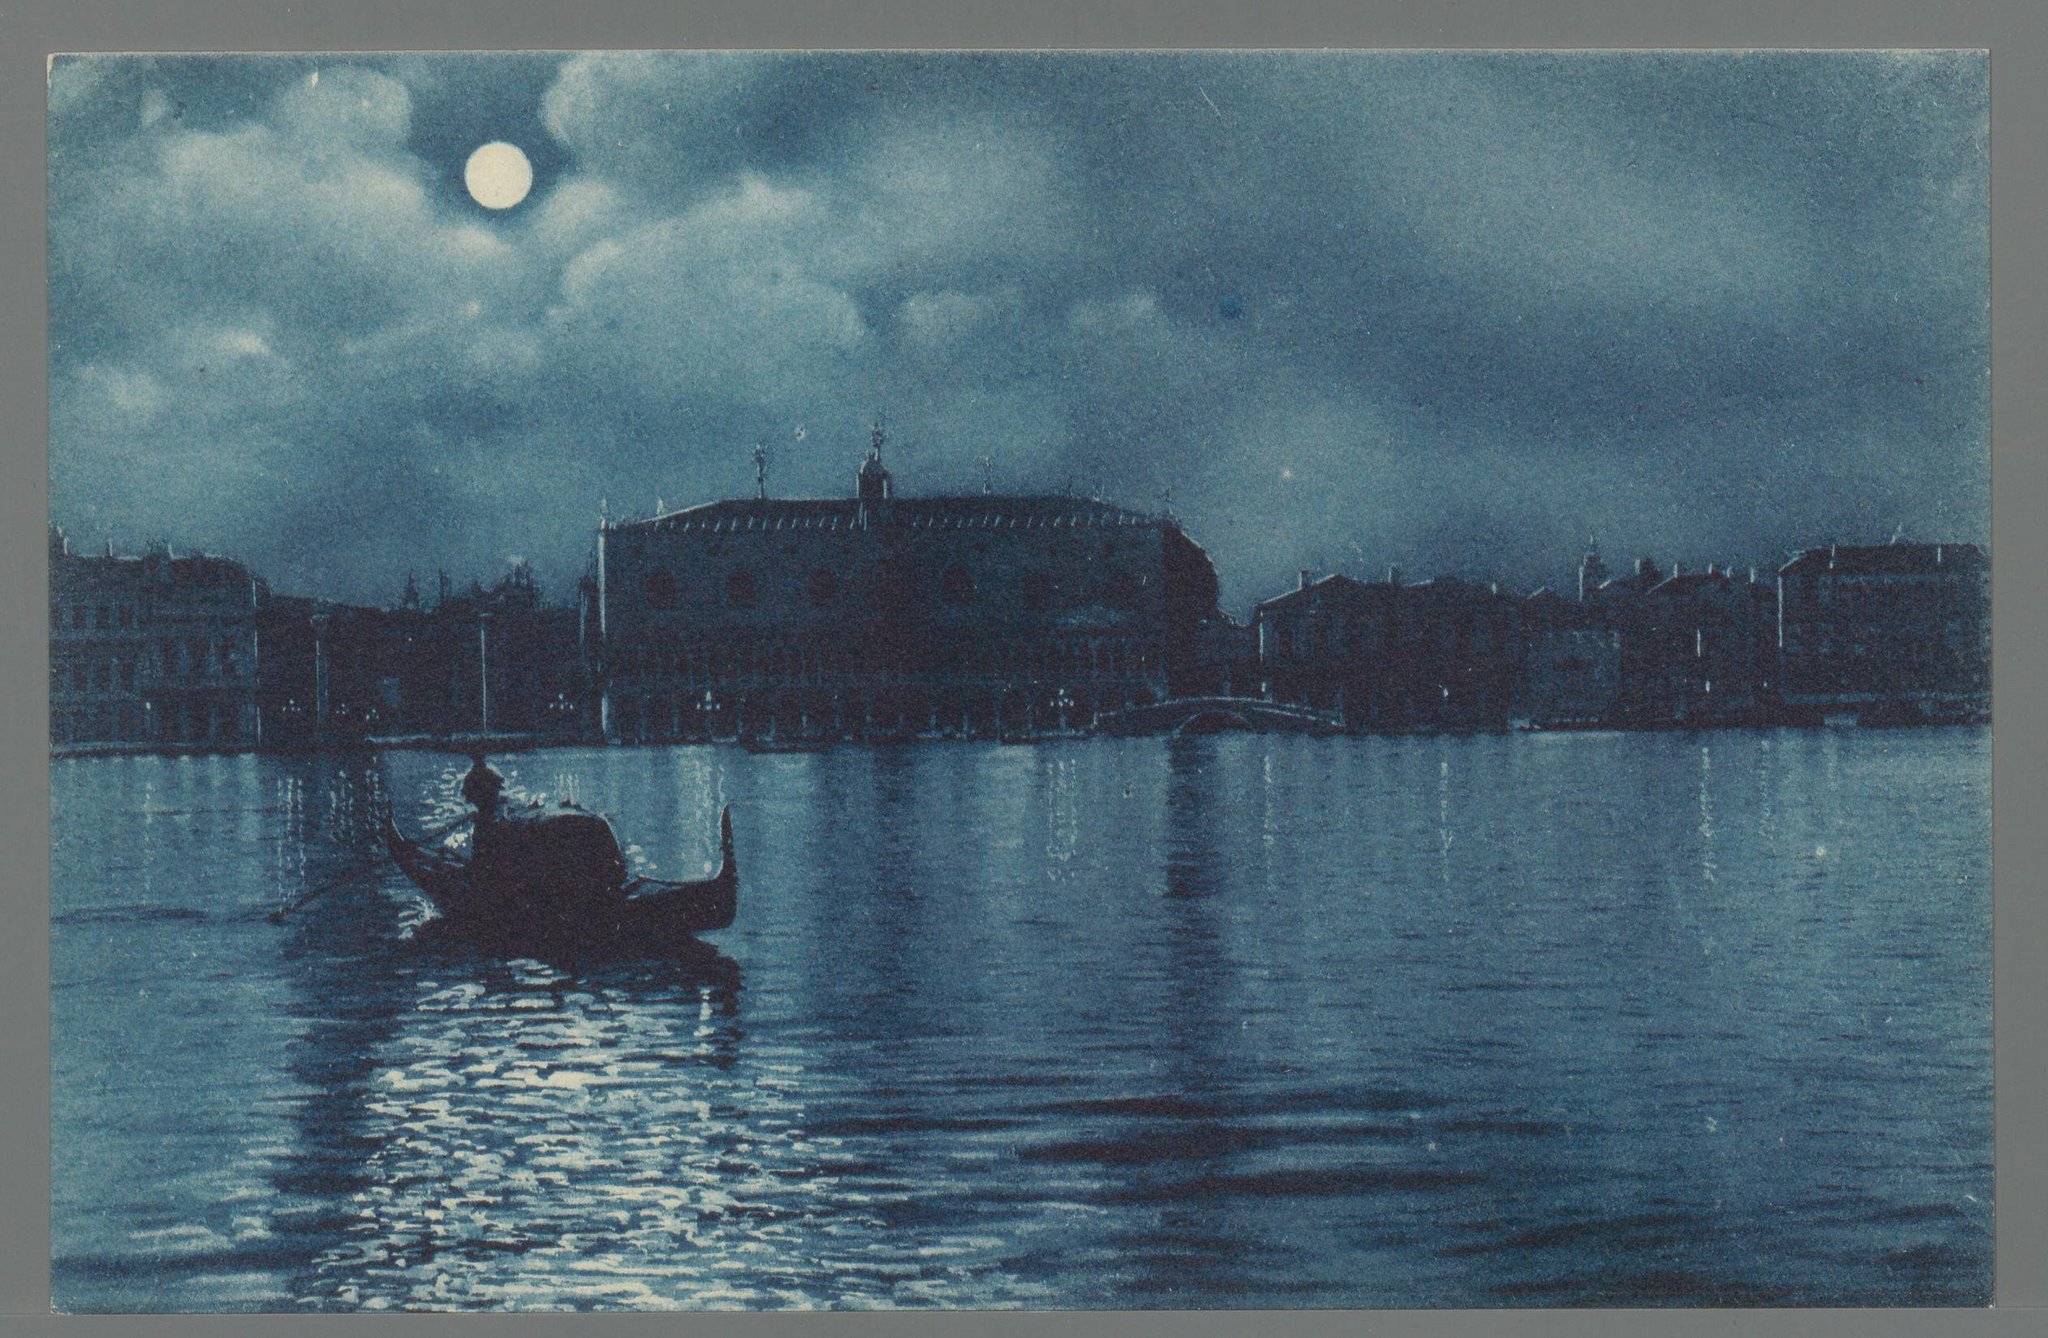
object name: ansichtkaart, prentbriefkaart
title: Venezia. Panorama dal Mare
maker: Anonymous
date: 1900-1905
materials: cardboard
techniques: photograph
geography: venice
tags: moonlight, prospect of city, town panorama, silhouette of city, sea, venice